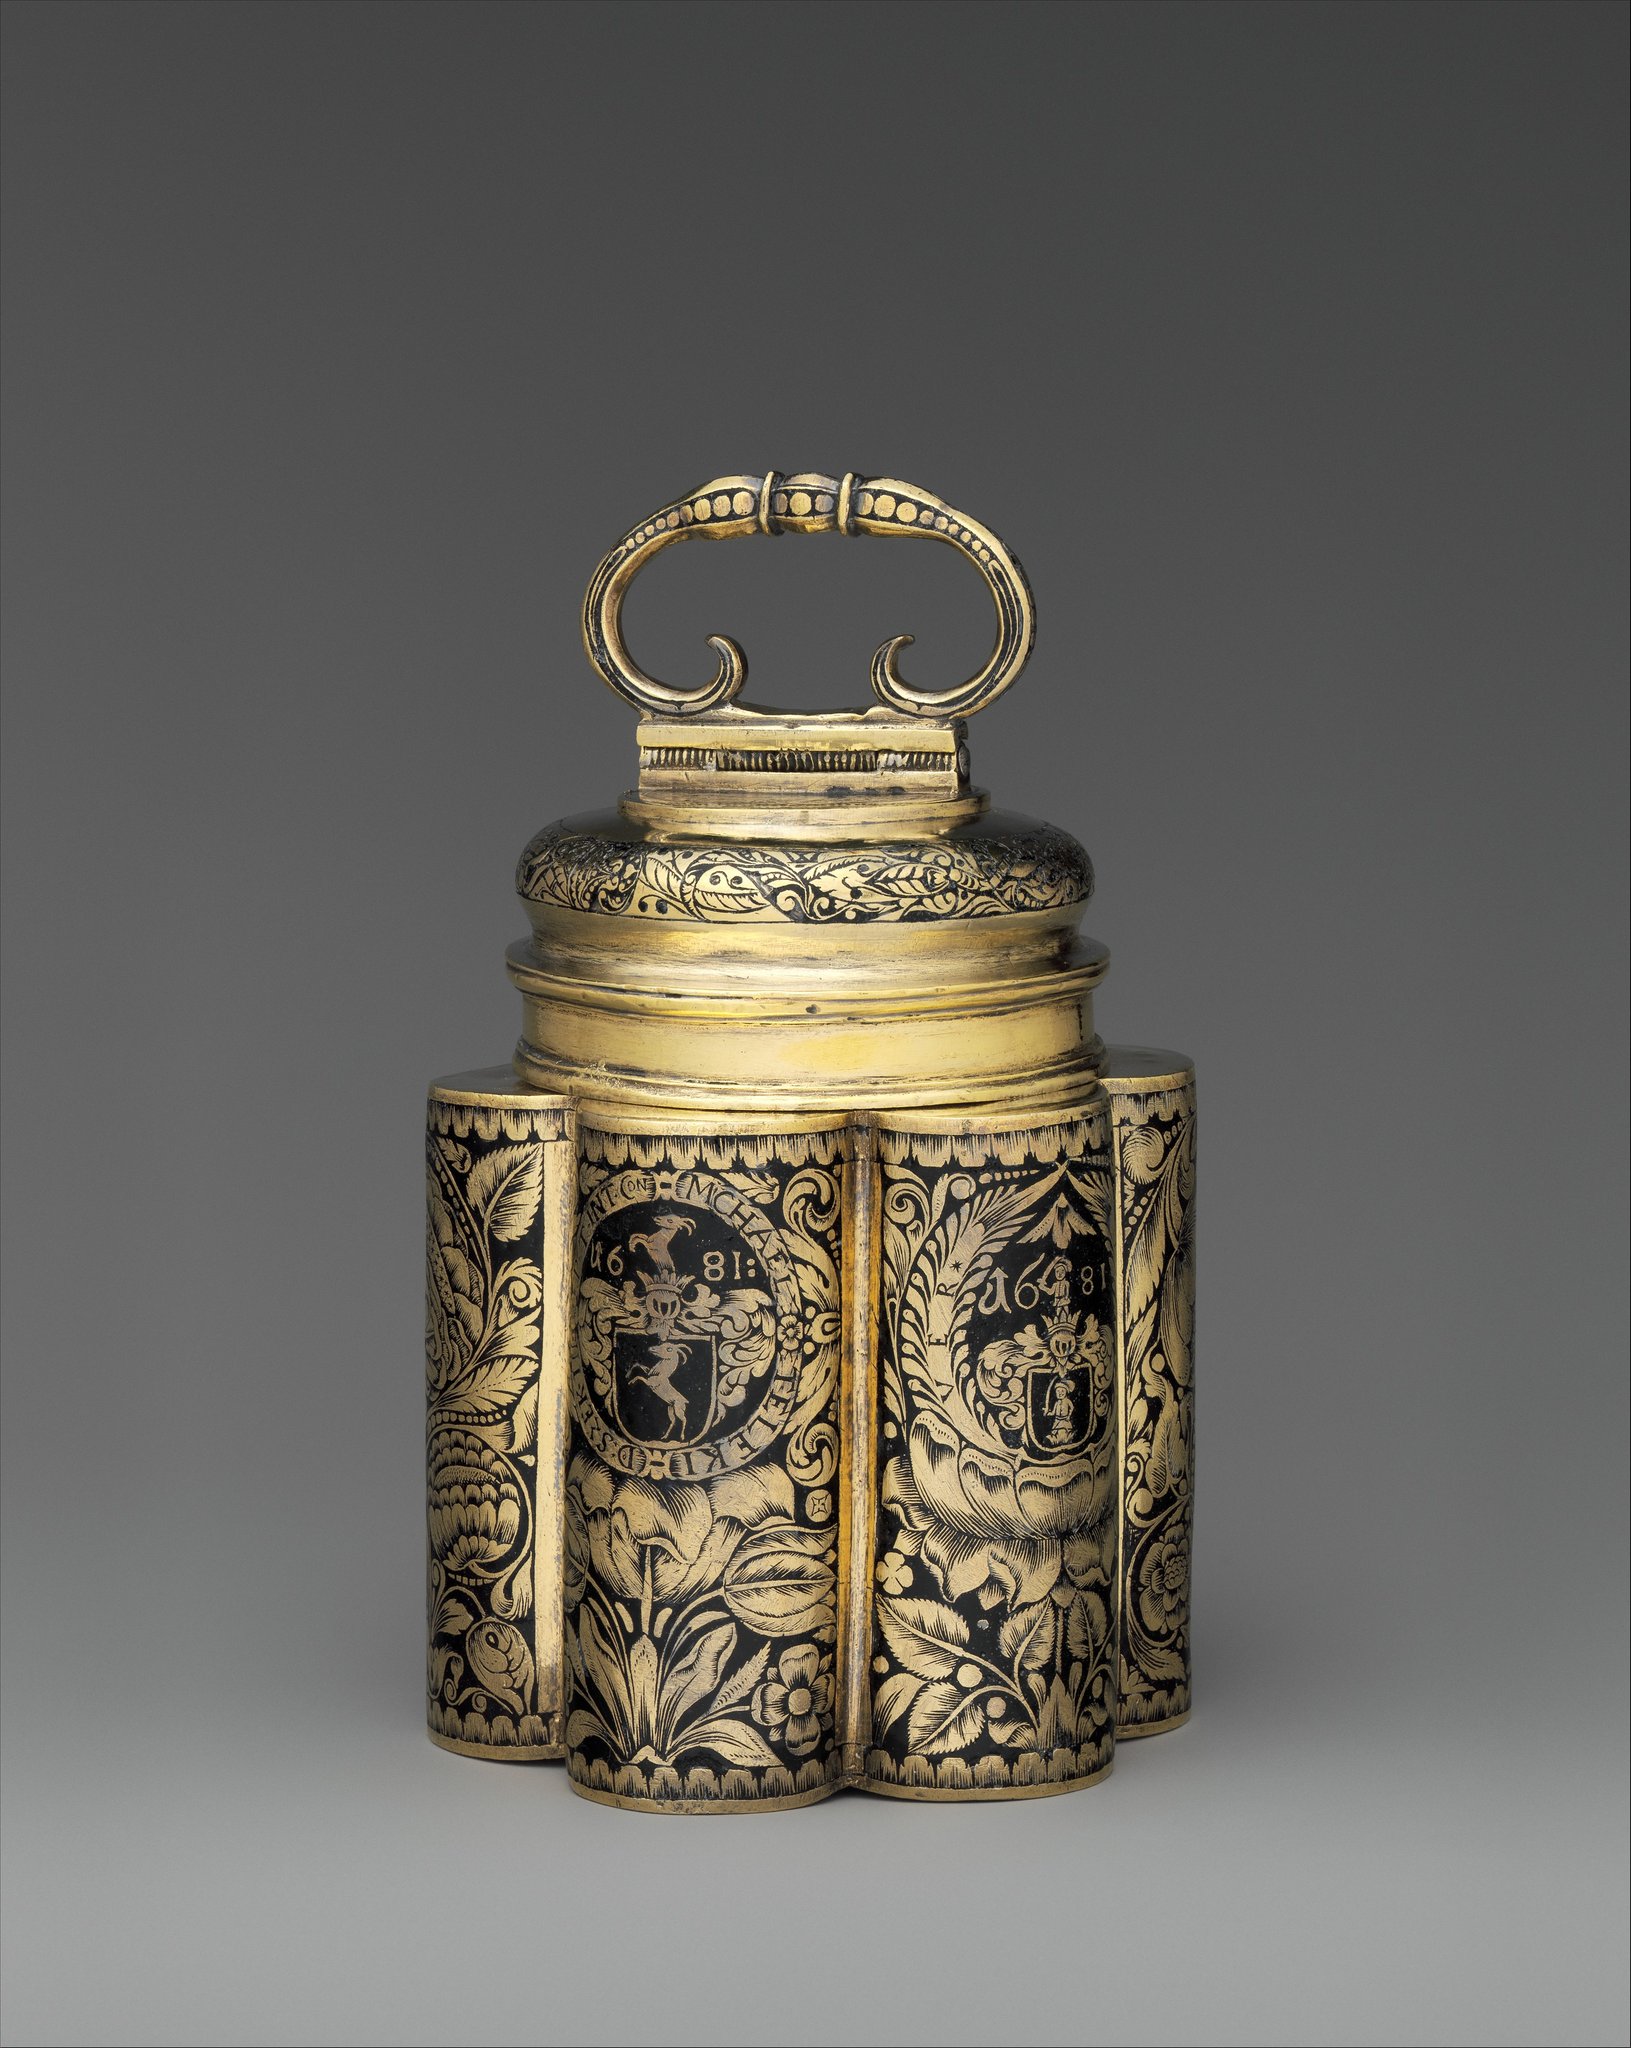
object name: canister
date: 1681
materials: enamel, gilt silver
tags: coat of arms